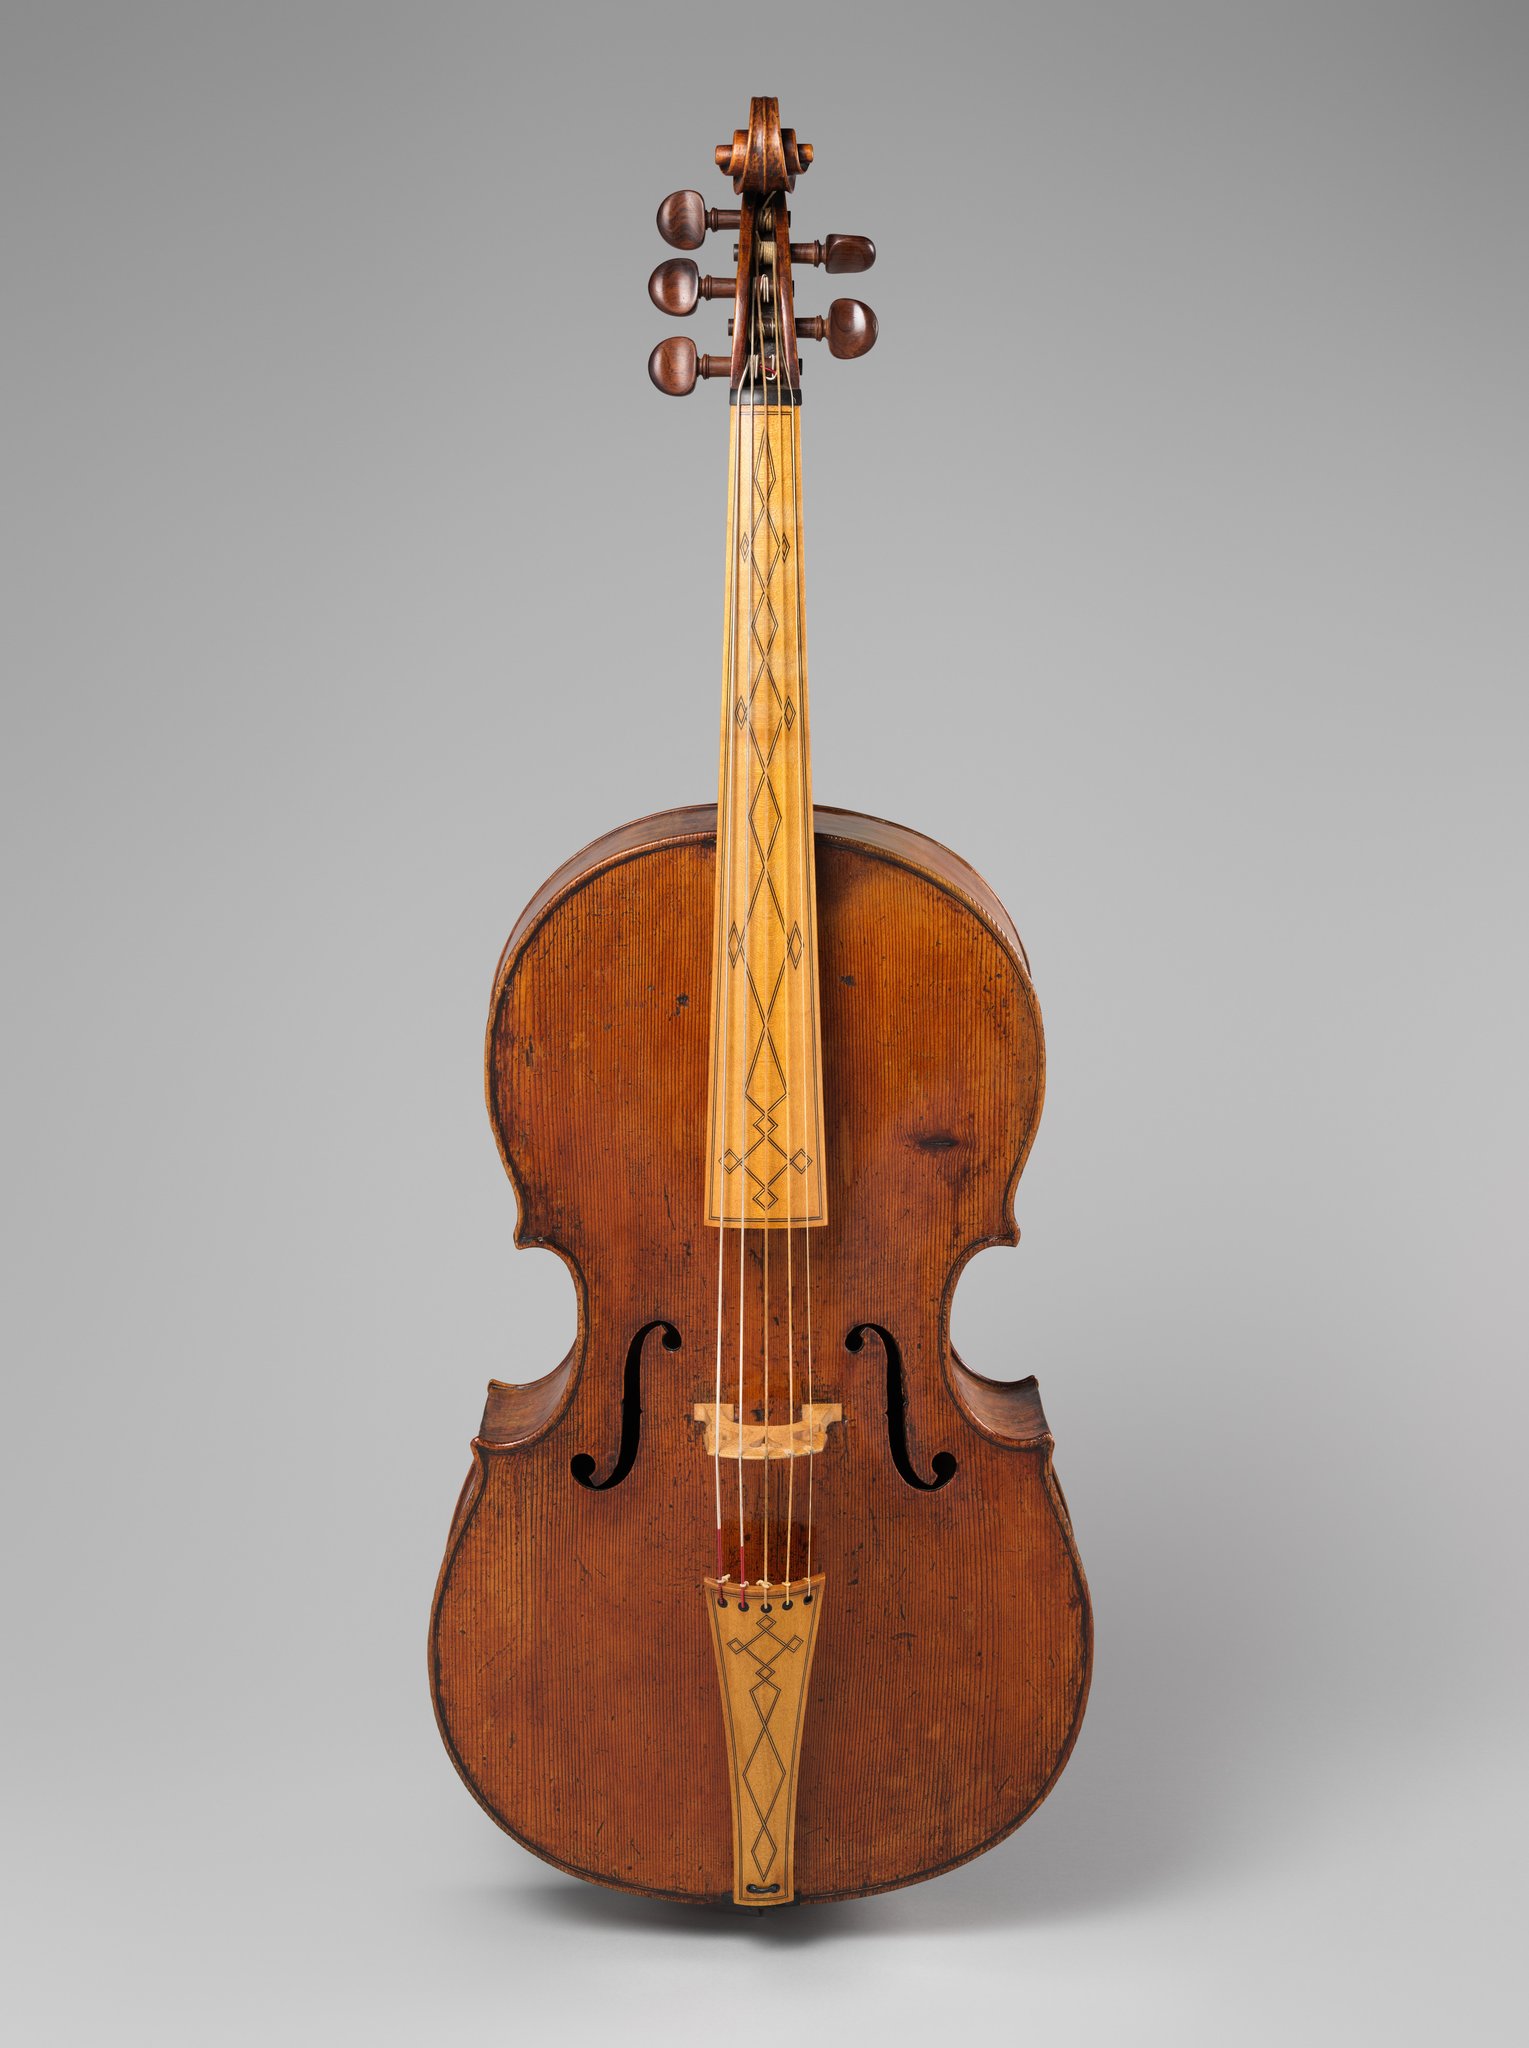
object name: cello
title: "Amaryllis Fleming" Cello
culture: italian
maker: brothers amati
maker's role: maker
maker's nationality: italian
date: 1610-1620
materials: wood, metal, varnish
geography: united states